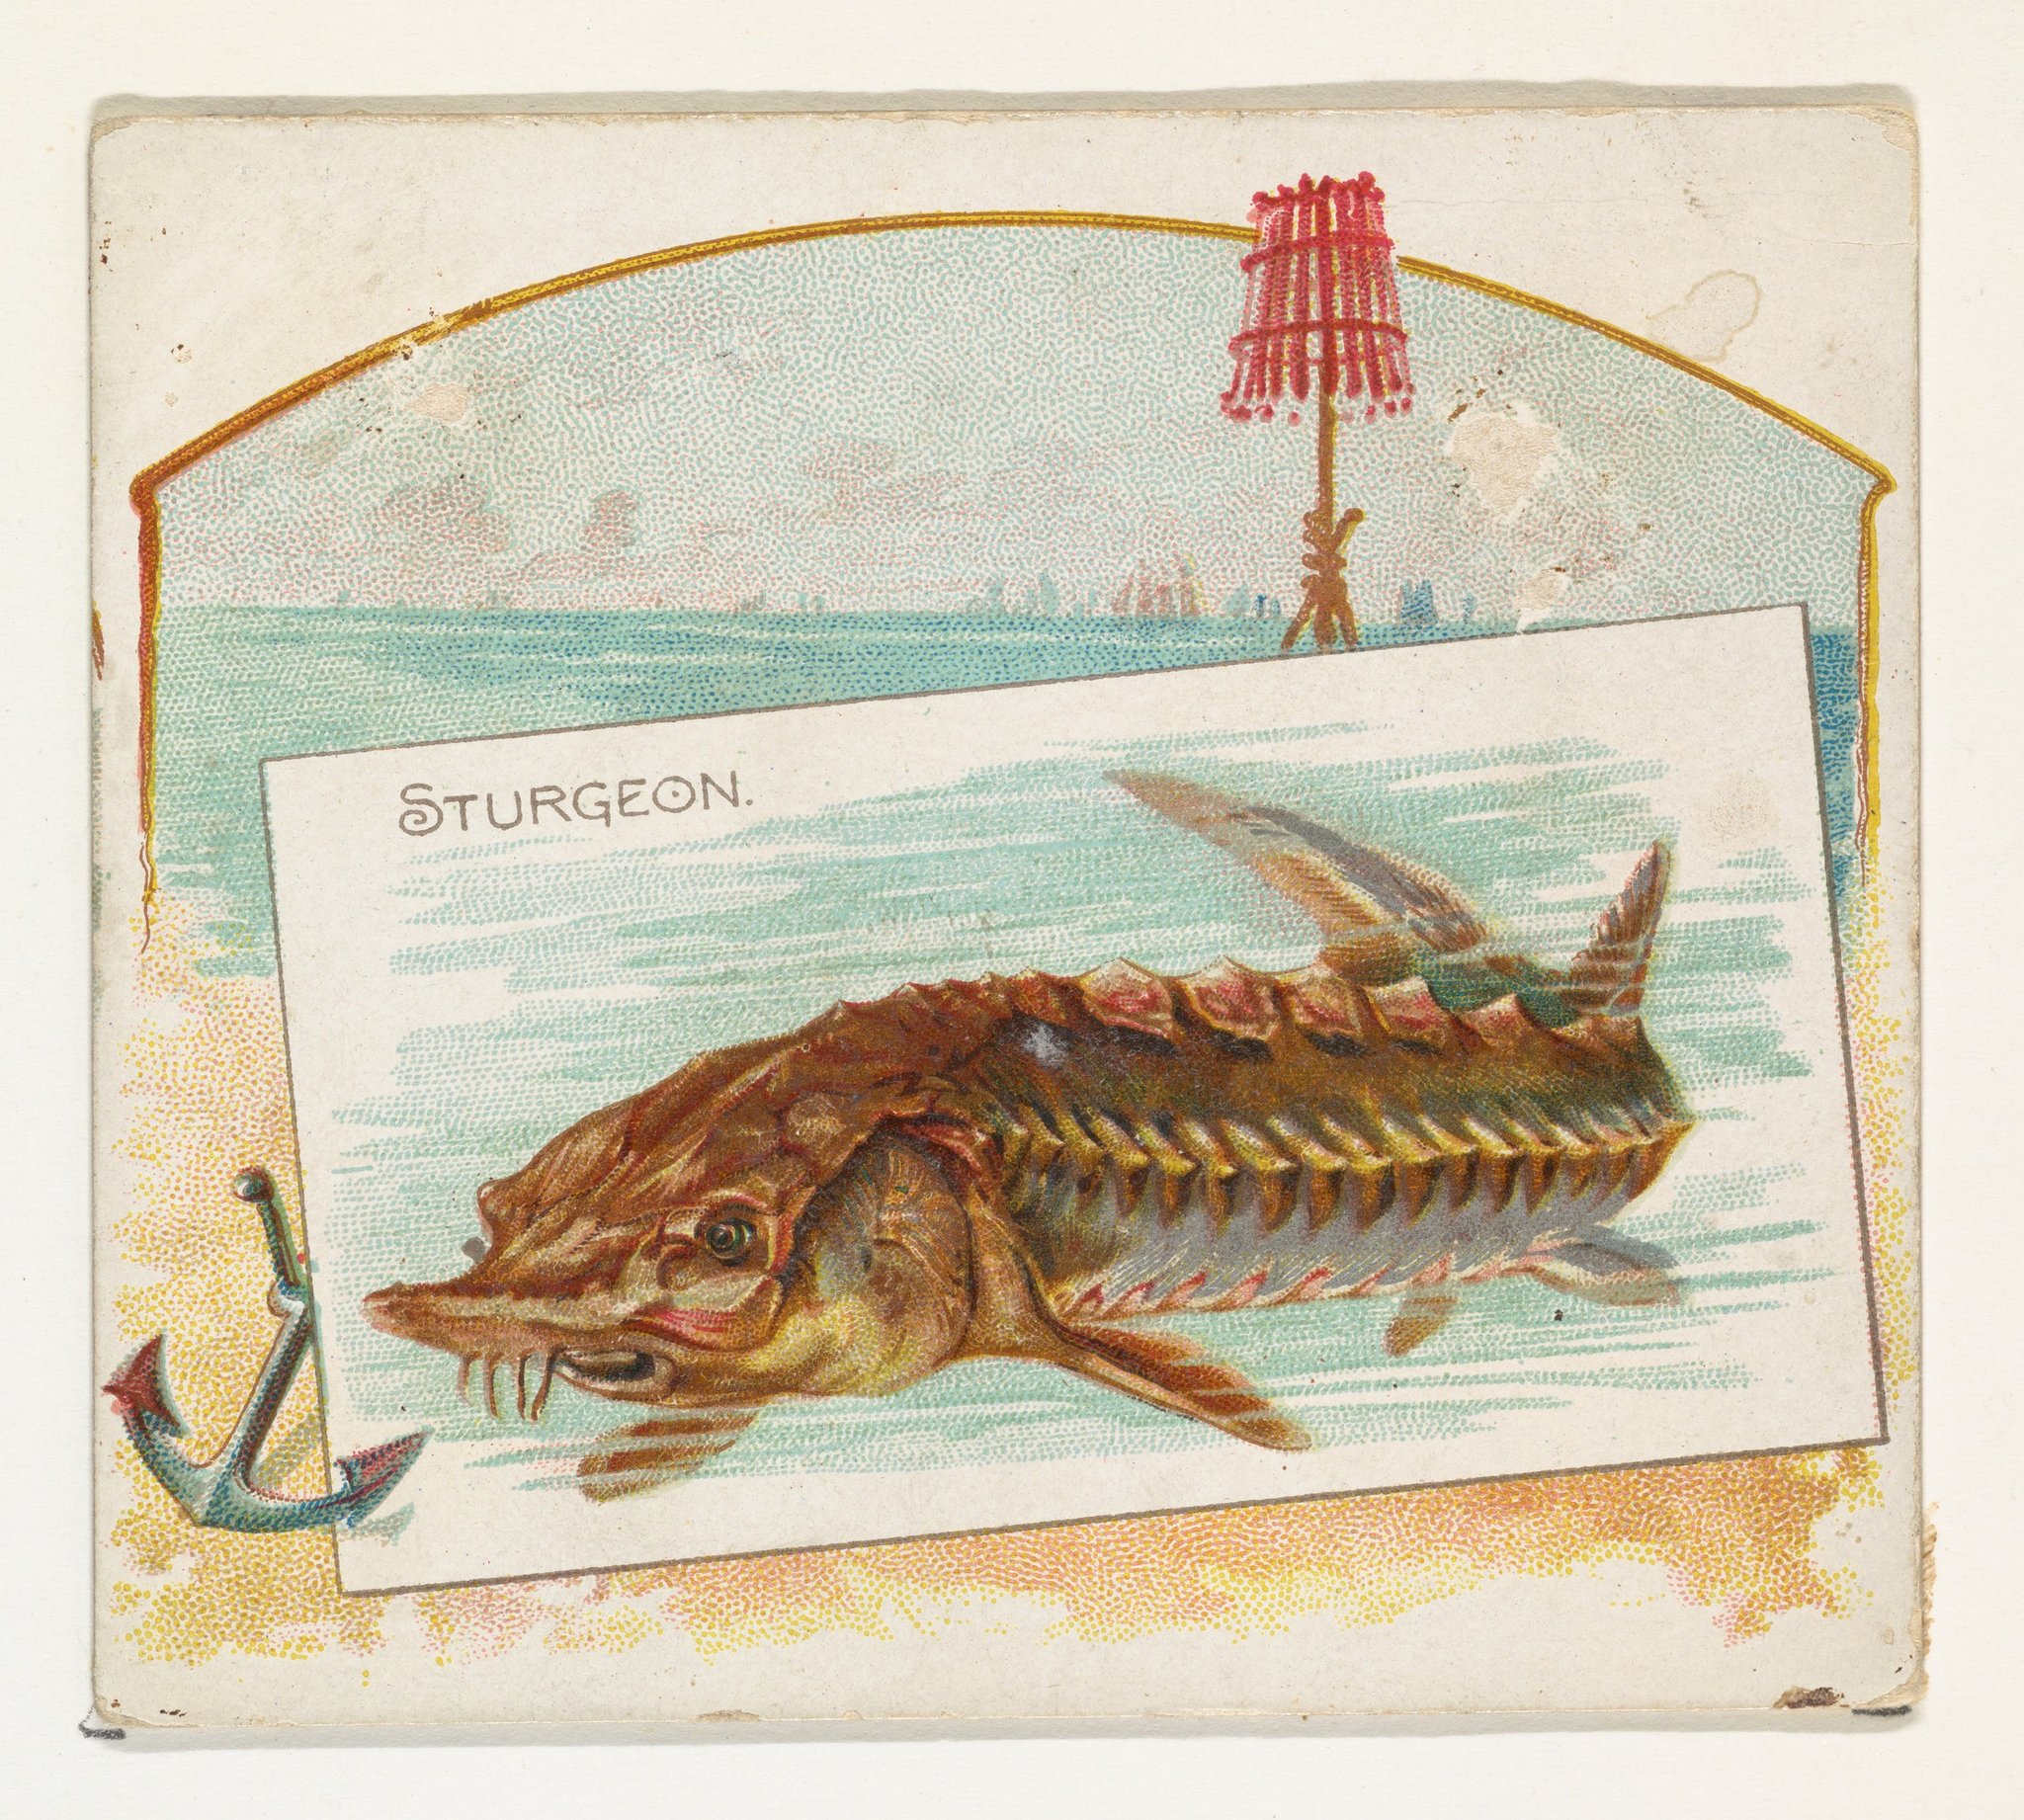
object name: print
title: Sturgeon, from Fish from American Waters series (N39) for Allen & Ginter Cigarettes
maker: allen & ginter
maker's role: publisher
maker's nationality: american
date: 1889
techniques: color lithograph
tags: fish